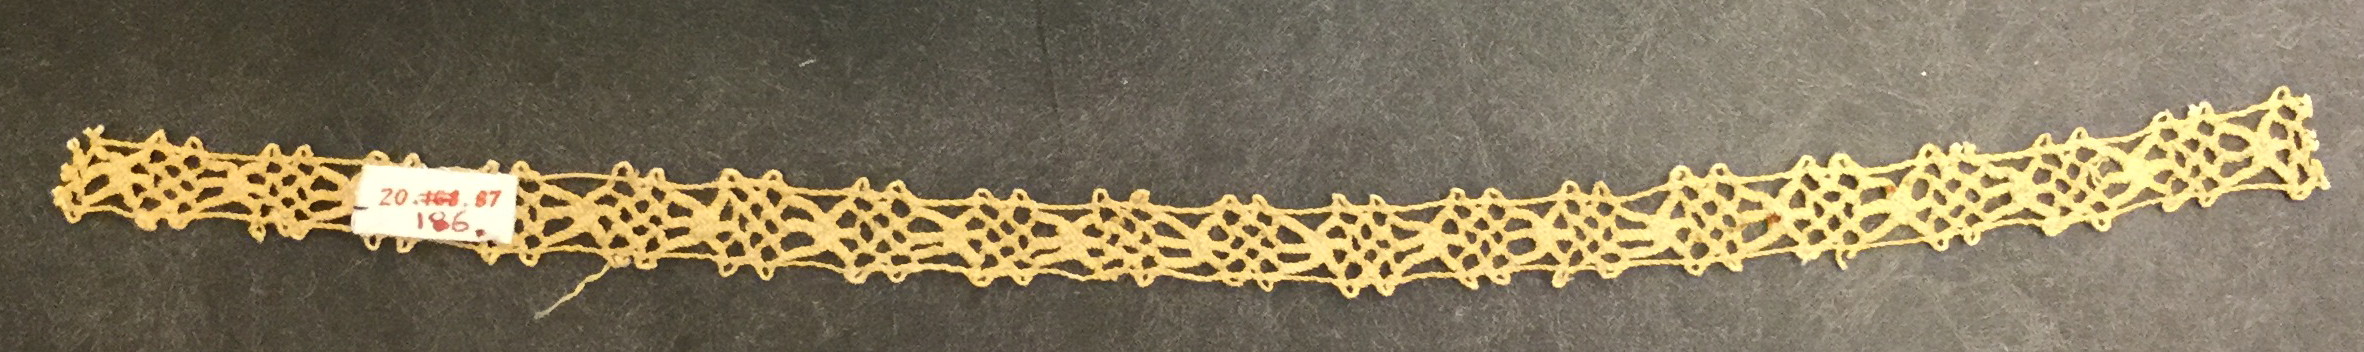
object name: insertion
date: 1501-1600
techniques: lace